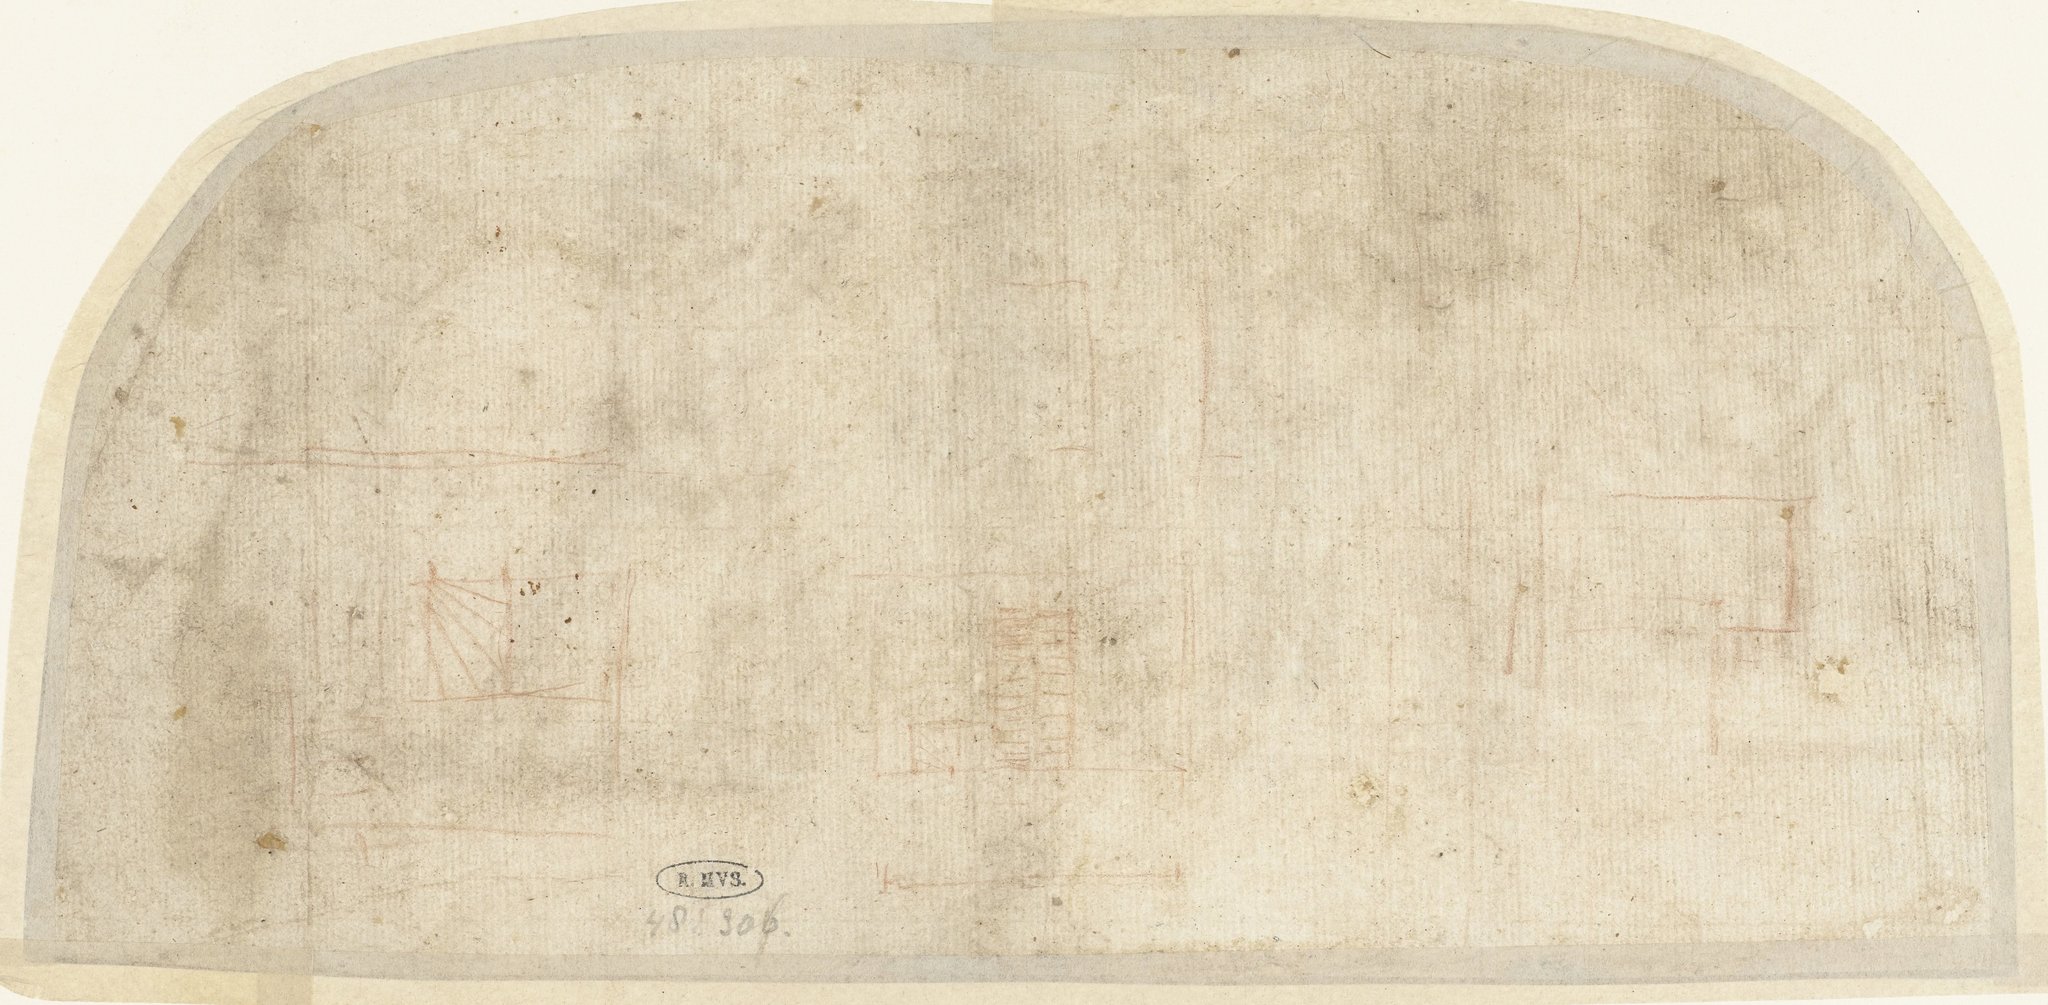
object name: drawing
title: Schetsen van een plattegrond (?)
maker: Anonymous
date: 1620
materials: chalk, paper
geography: tuscany